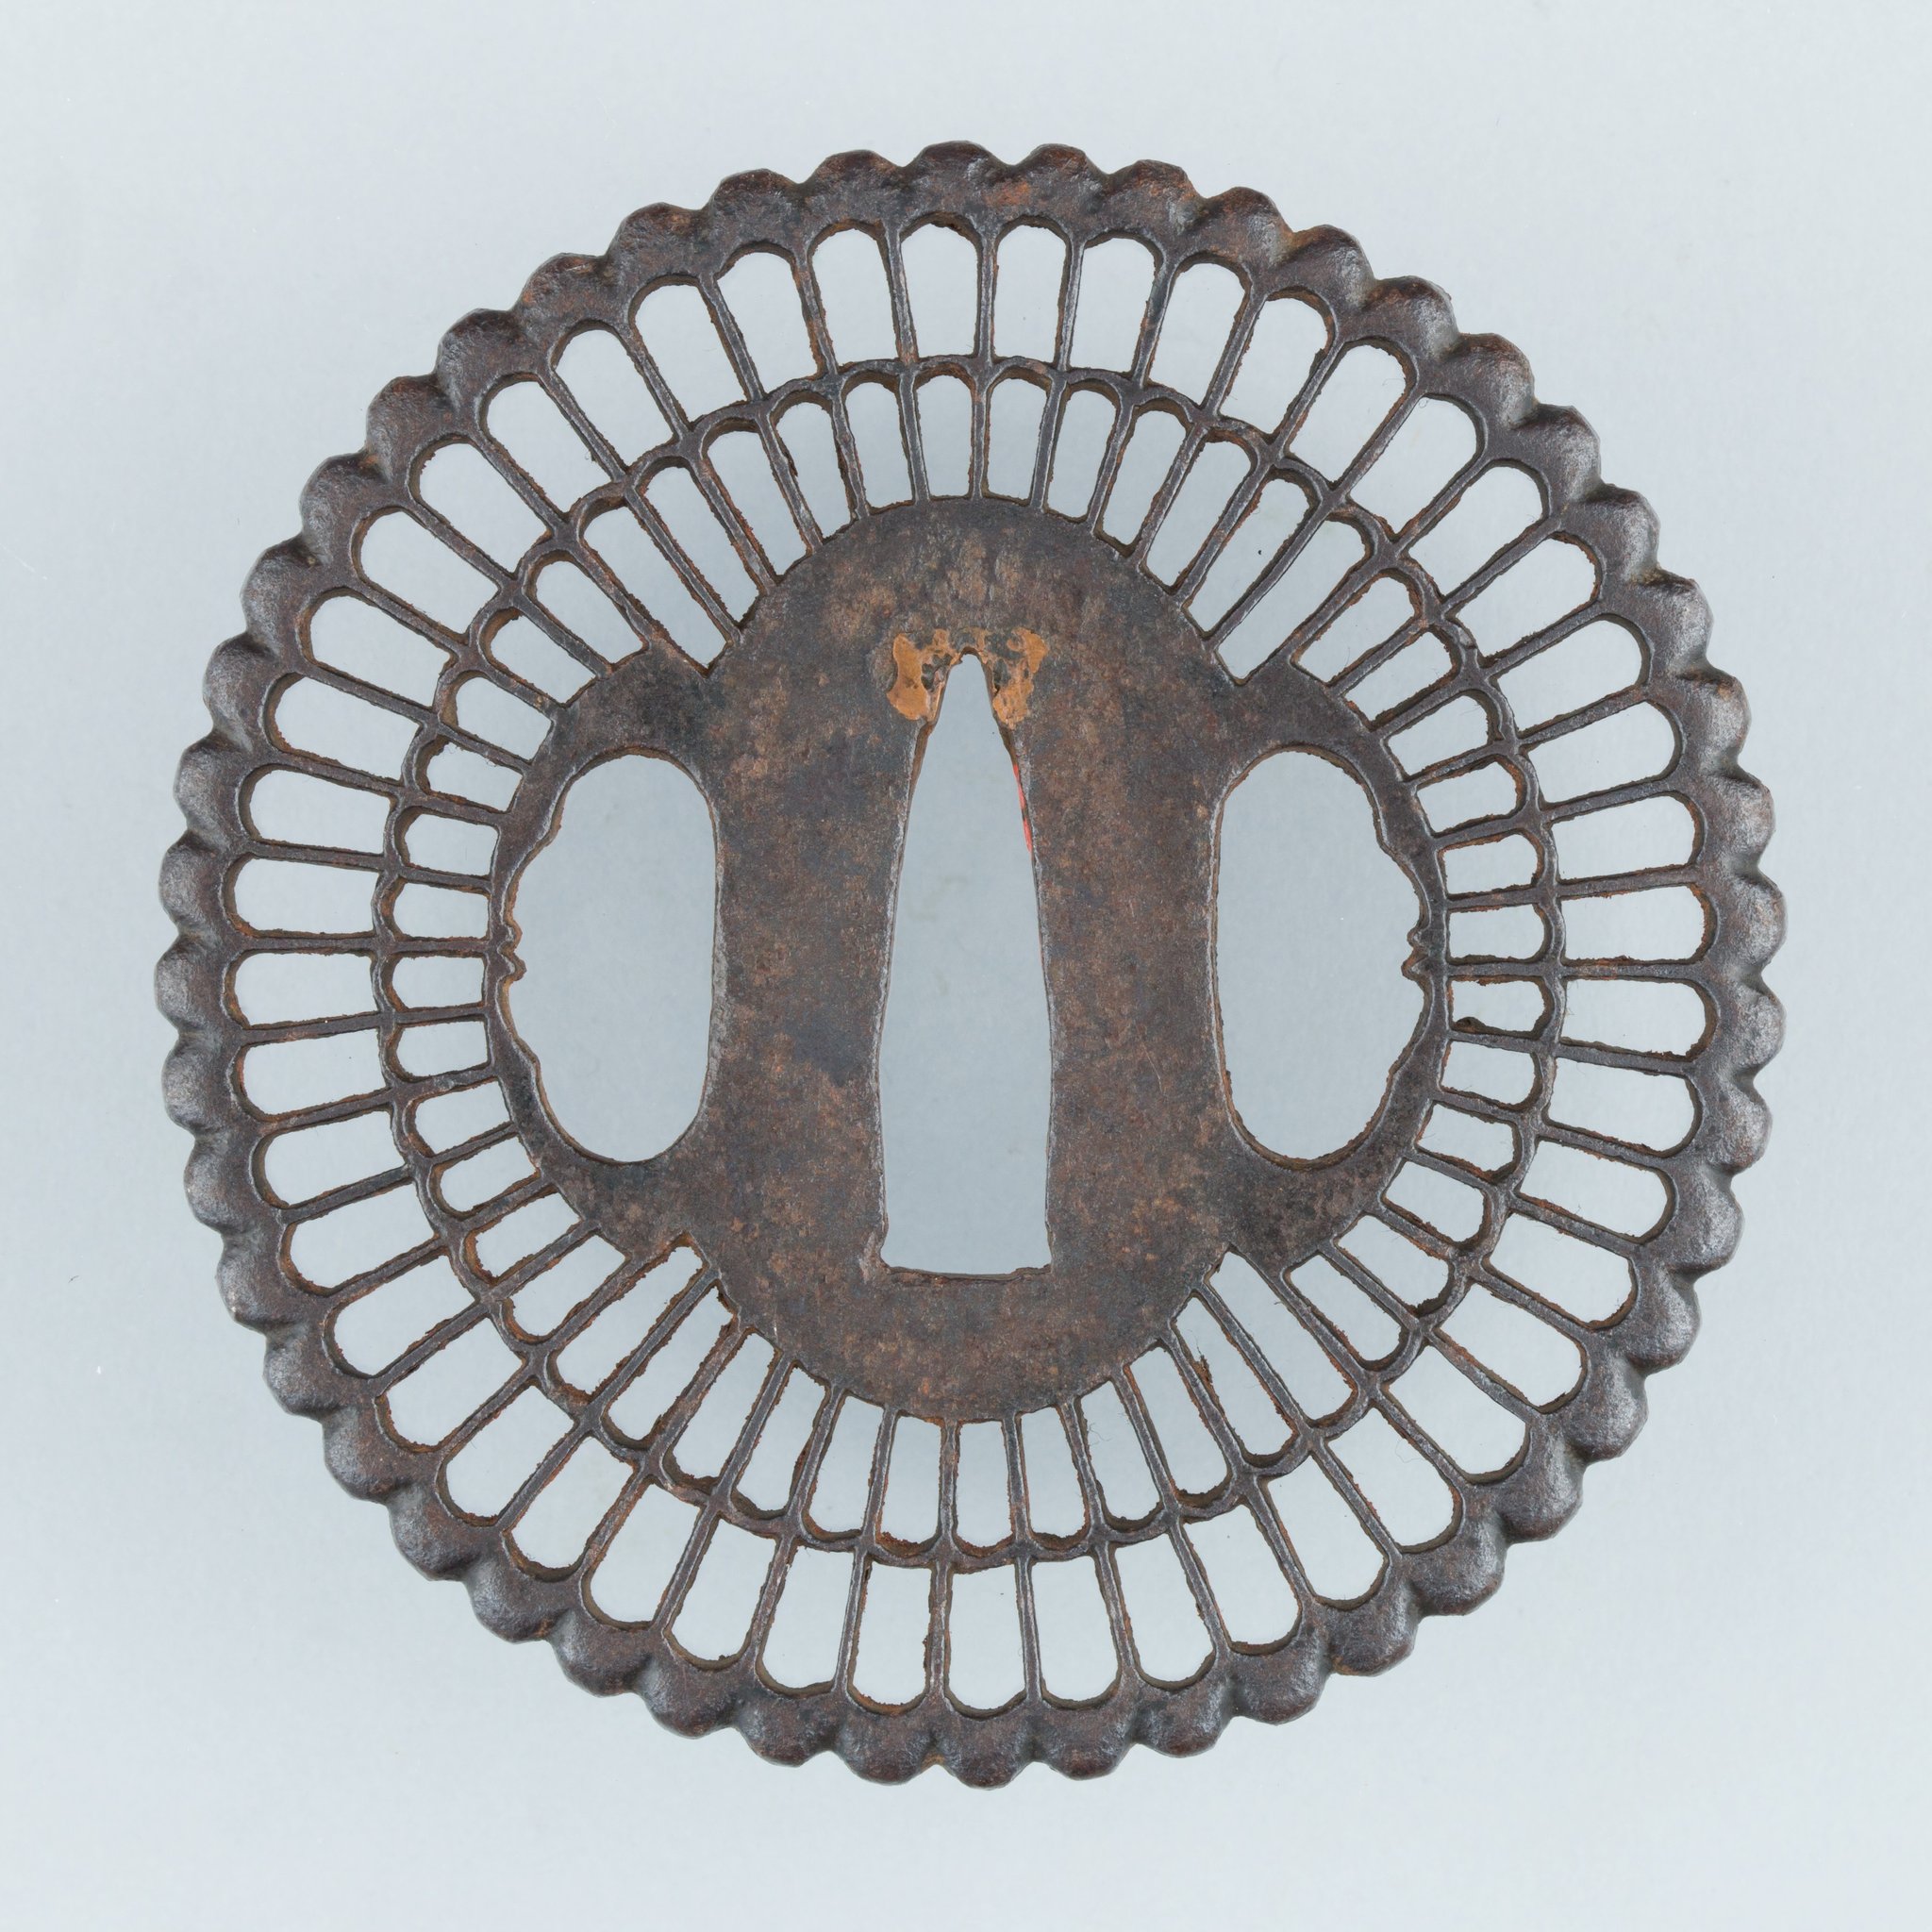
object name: sword guard tsuba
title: Sword Guard (Tsuba)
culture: japanese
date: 1615-1868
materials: copper, iron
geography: japan